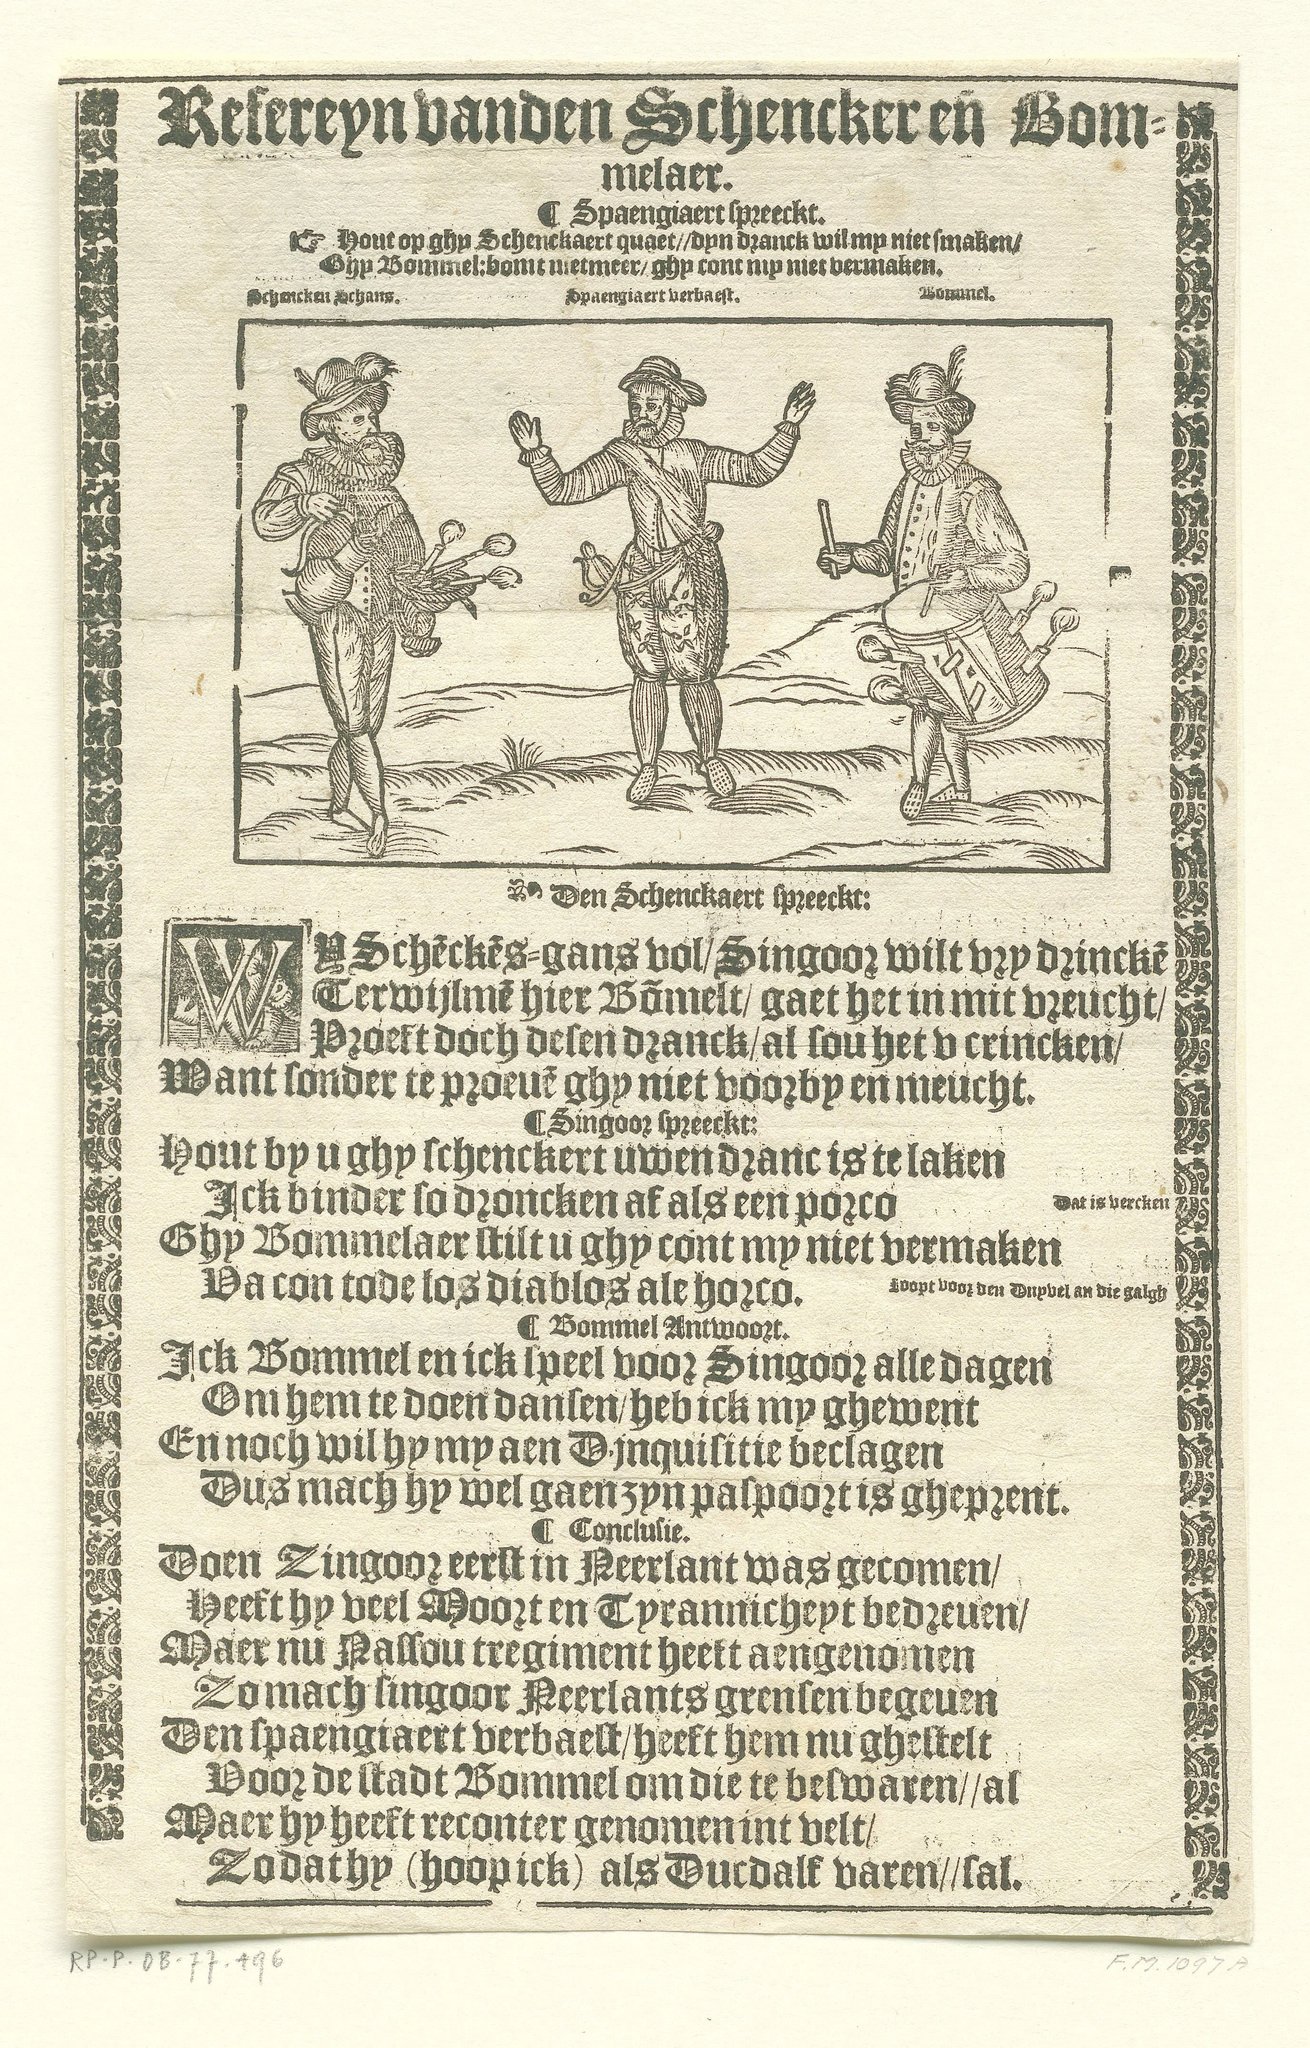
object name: print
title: Refrein op de belegeringen van Schenckenschans en Zaltbommel, 1599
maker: Anonymous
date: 1599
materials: paper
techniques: letterpress printing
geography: northern netherlands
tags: the hague, maurice (prince of orange)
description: Refrein op de mislukte belegeringen door het Spaanse leger onder Mendoza van Schenckenschans en Zaltbommel, verdedigd door het Staatse leger onder Maurits van eind april tot mei 1599. Drie krijgslieden naast elkaar staand. De Staatse soldaten aangeduid als 'Schenken Schans' en 'Bommel' en de Spanjaard als 'Spaengiaert verbaest'. Onder de afbeelding drie vierregelige versjes waarin de figuren om beurten spreken. De tekst eindigt met een conclusie van acht regels. In ornamentrand.